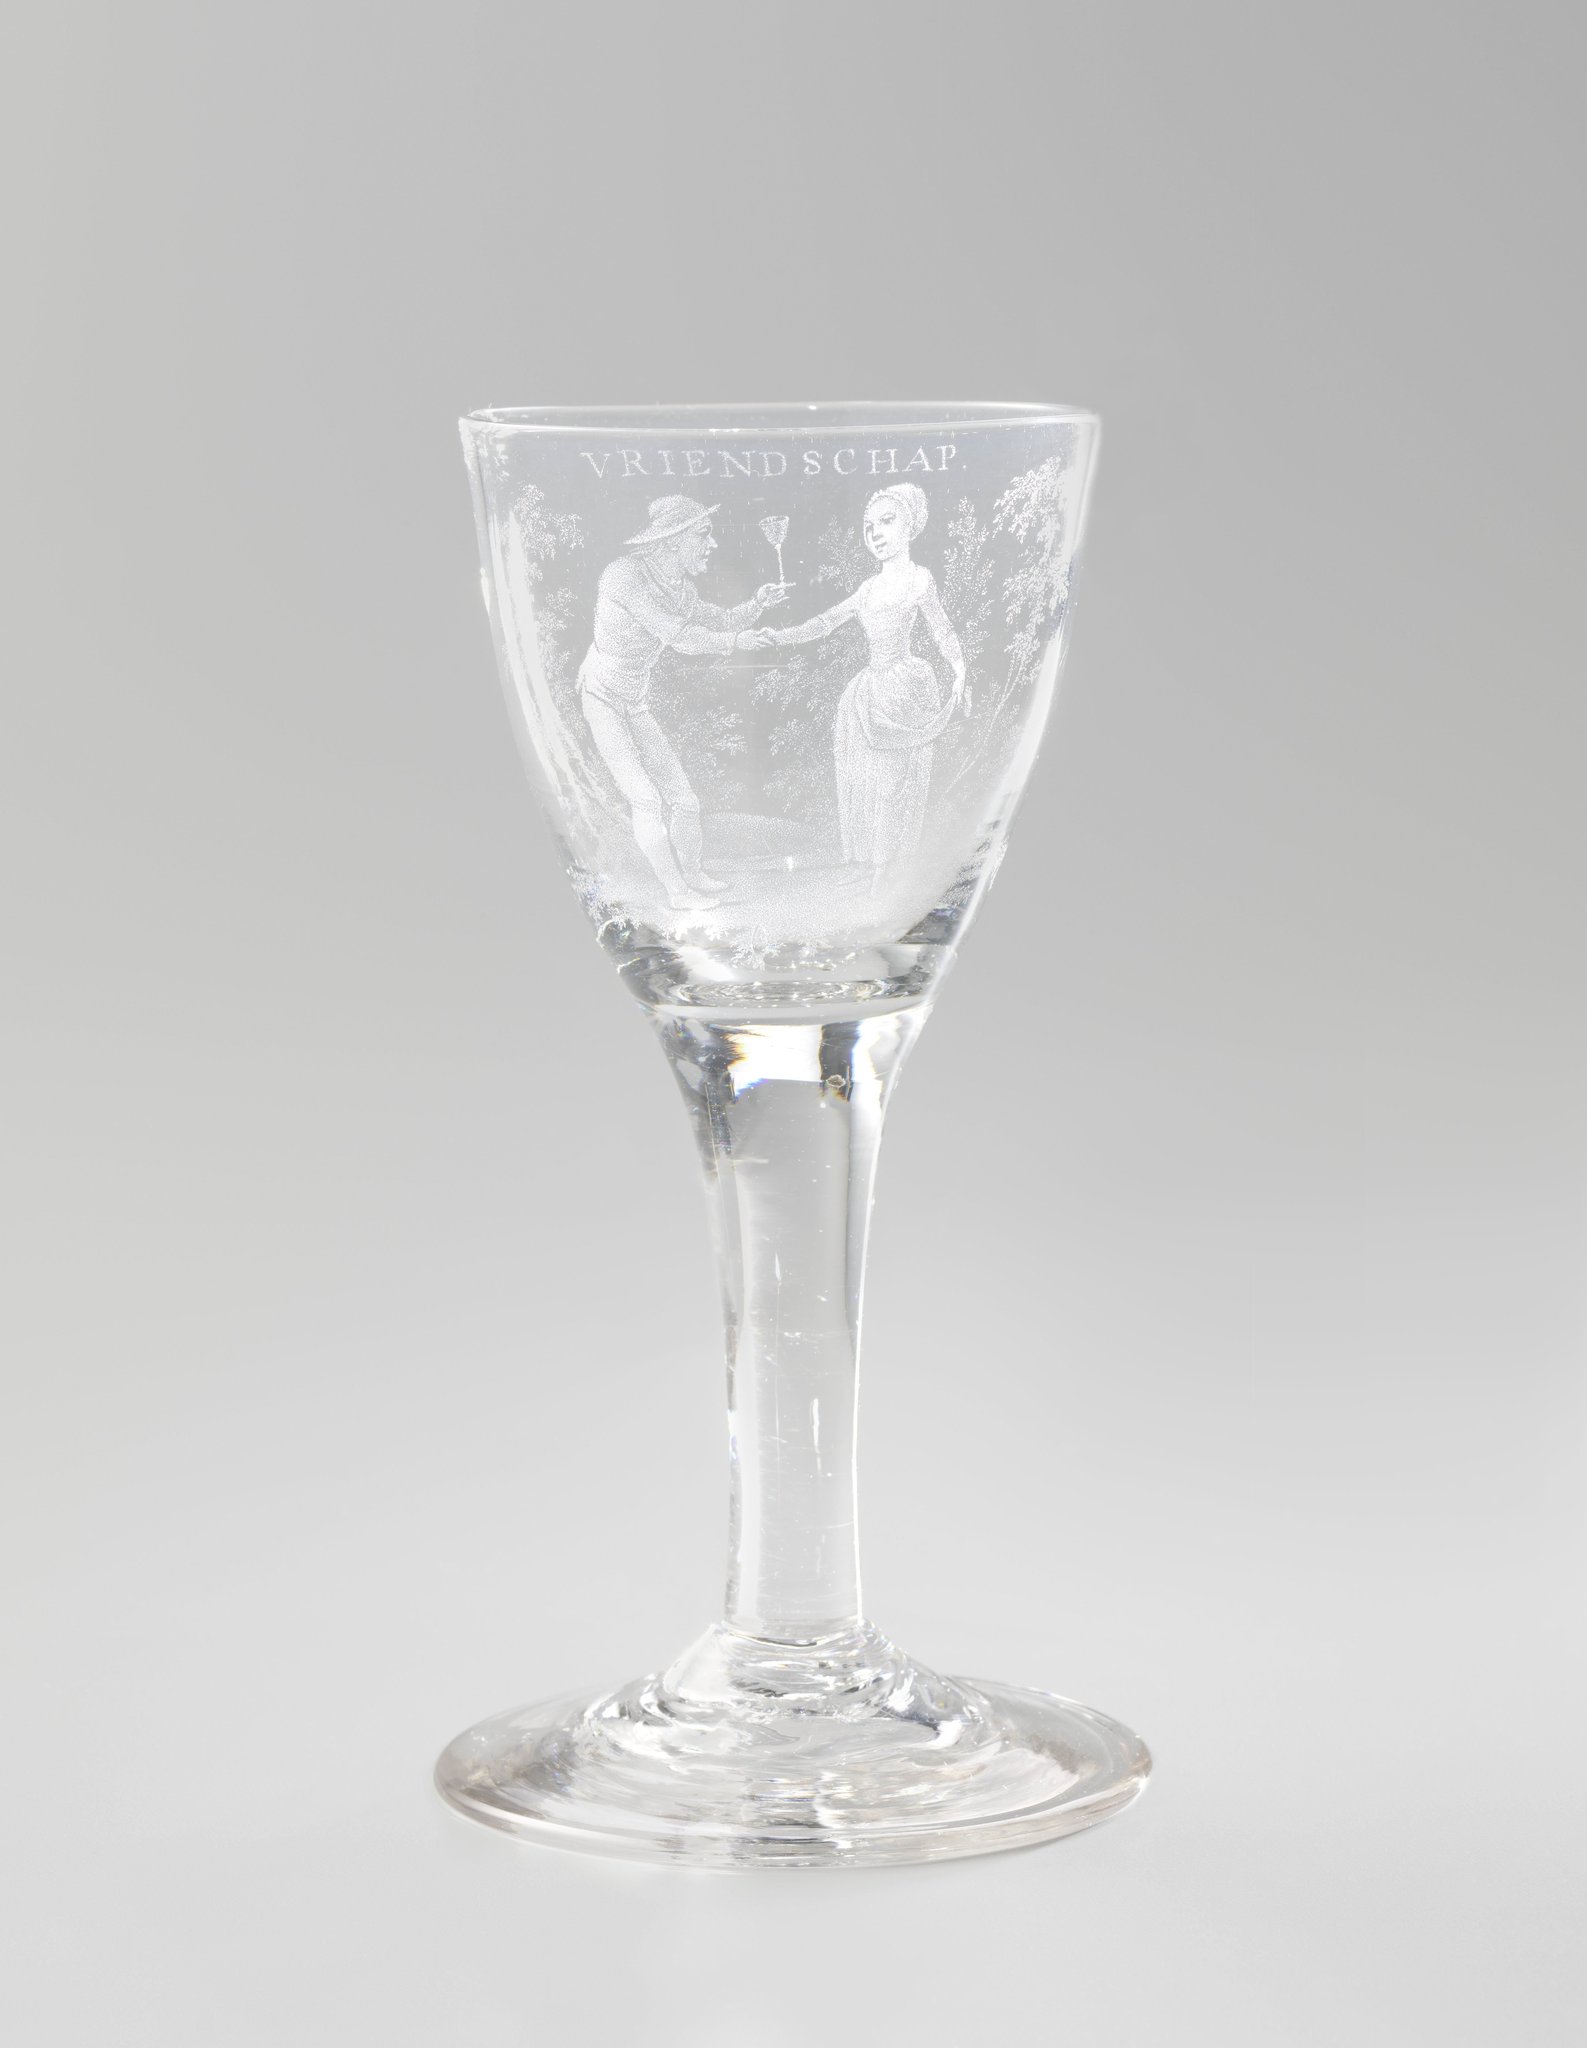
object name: goblet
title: Wine glass with an Allegory of Friendship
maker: david wolff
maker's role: glasgraveur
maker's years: 1732-1798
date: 1775-1798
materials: glass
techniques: glassblowing, engraving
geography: northern netherlands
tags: friendship; 'amicitia' (ripa) (+ 'exemplum', representation of exemplary (historical) event), gripping someone by the hand or the wrist; clasped hands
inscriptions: inscription: ‘VRIENDSCHAP’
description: translation of inscription: Friendship